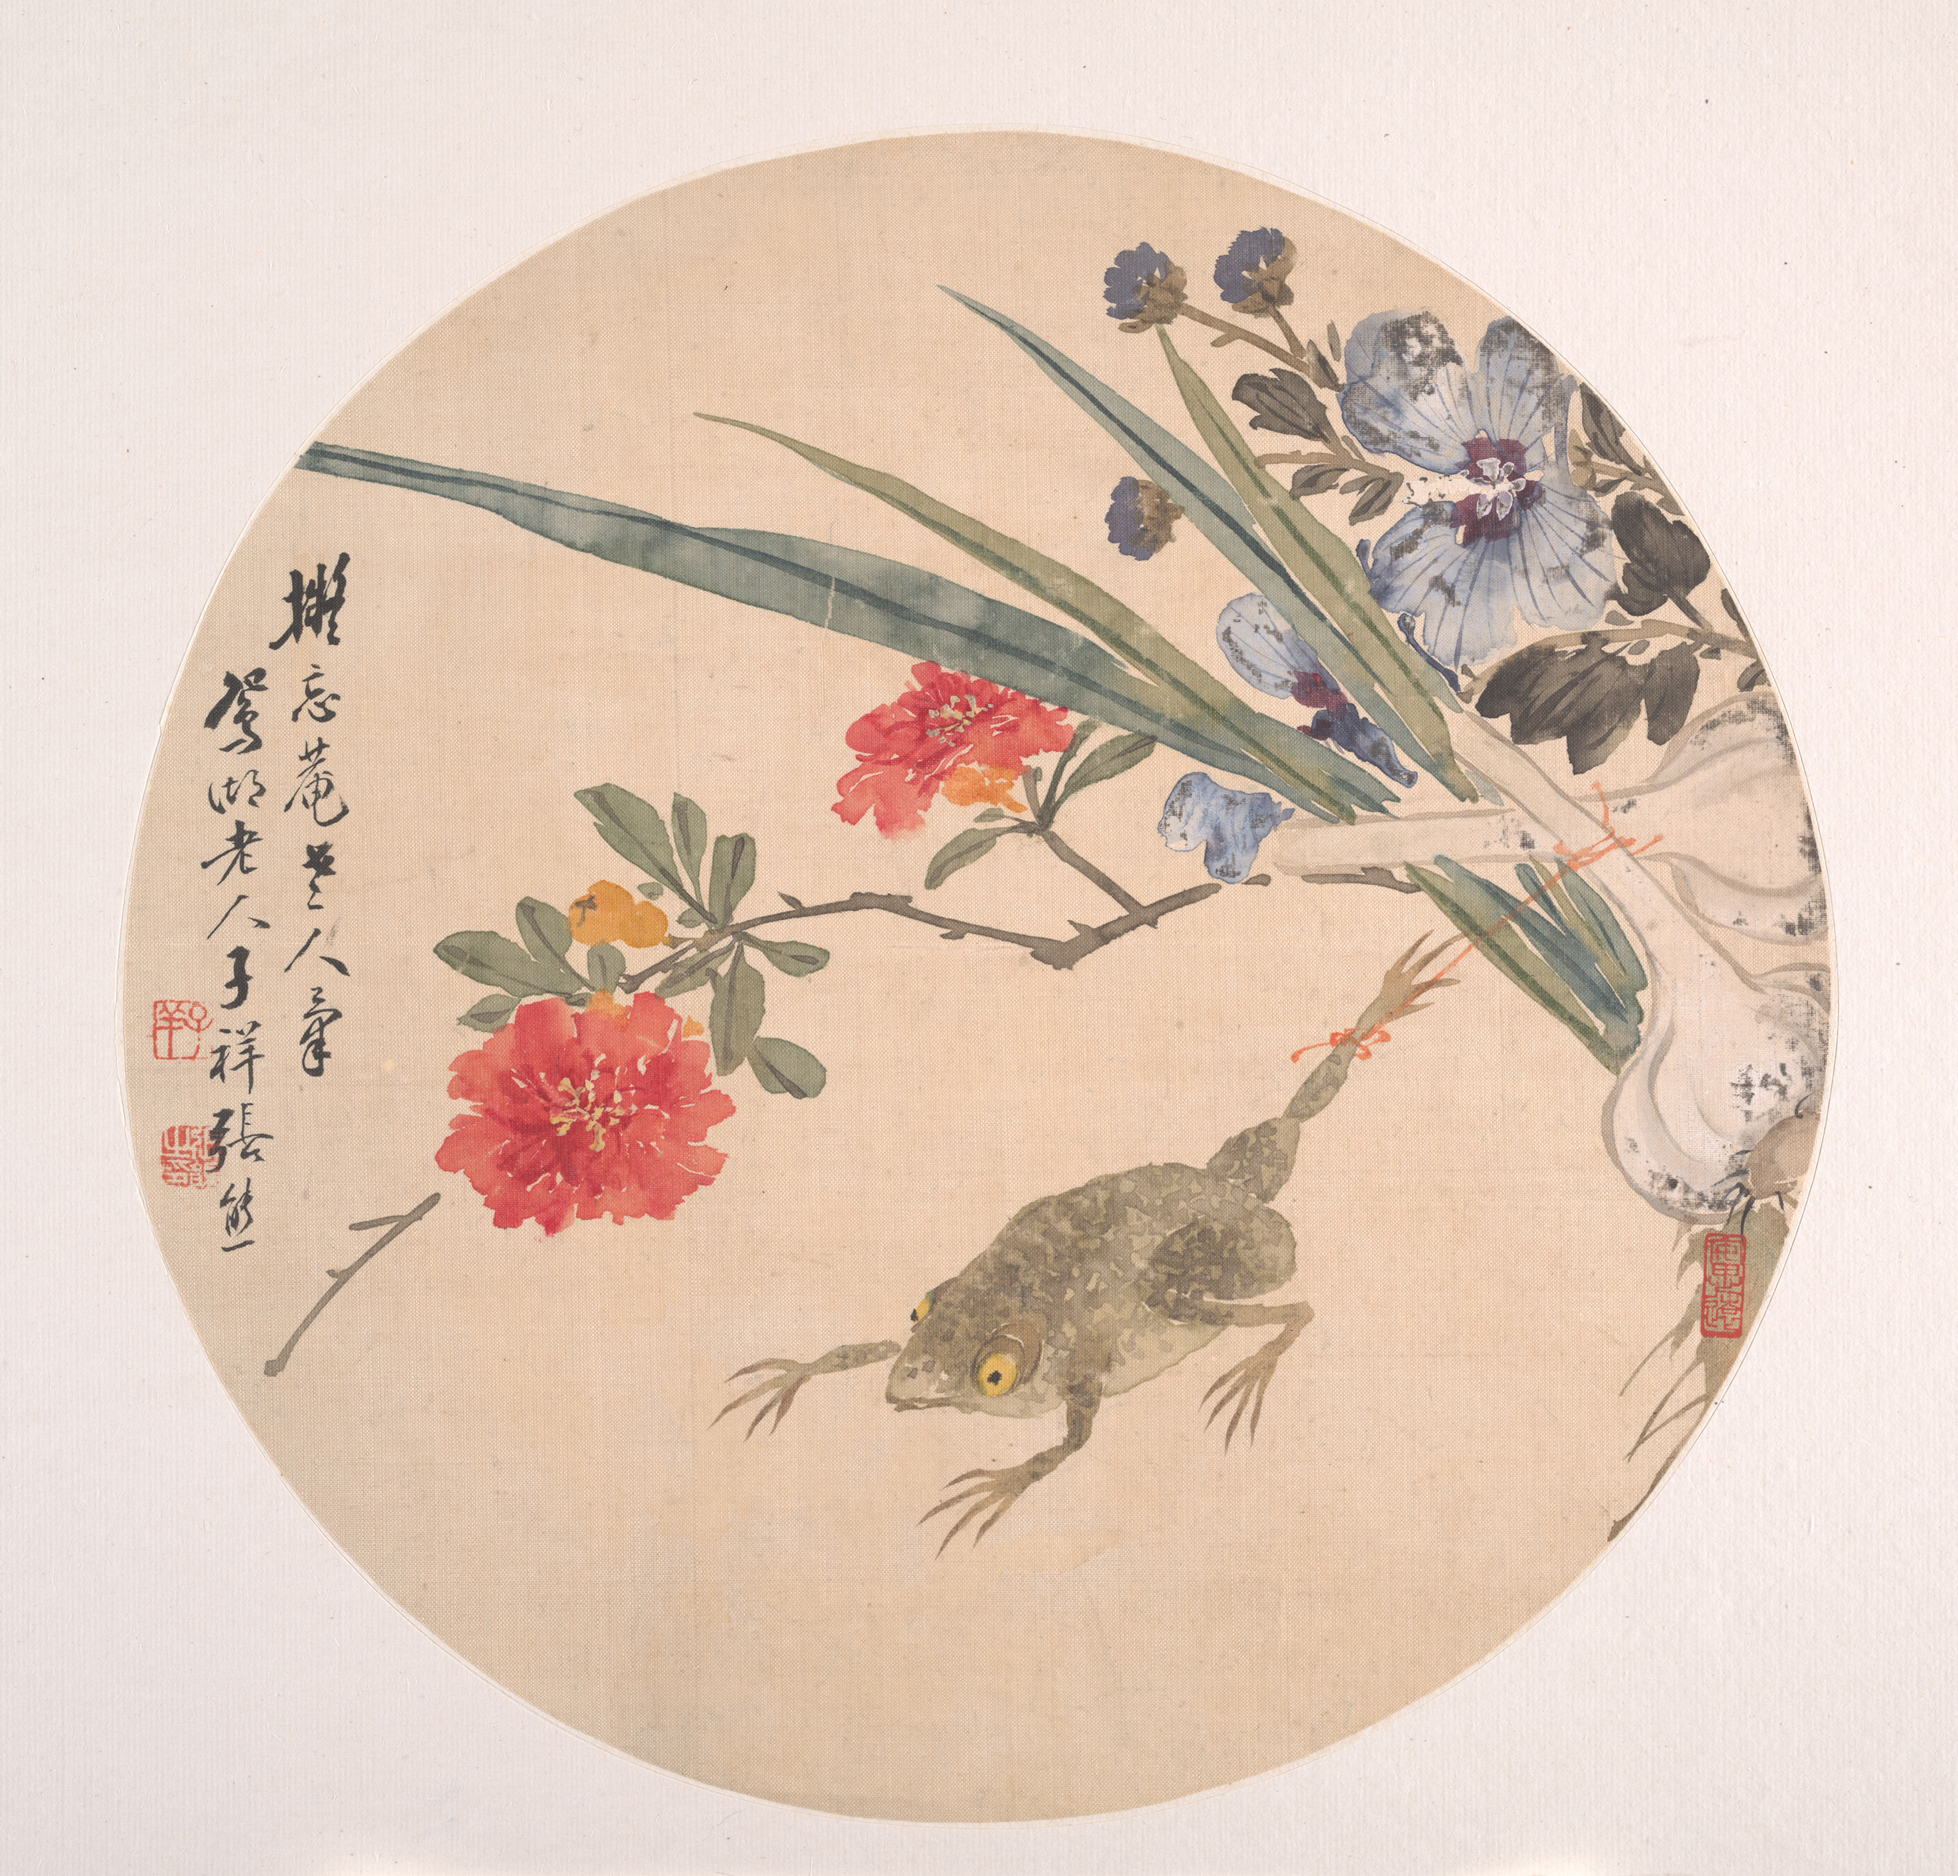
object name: fan mounted a an album leaf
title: Flower and Toad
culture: chinese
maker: zhang xiong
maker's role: artist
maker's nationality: chinese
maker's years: 1803-1886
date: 1803-1886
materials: ink, silk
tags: frogs,flowers